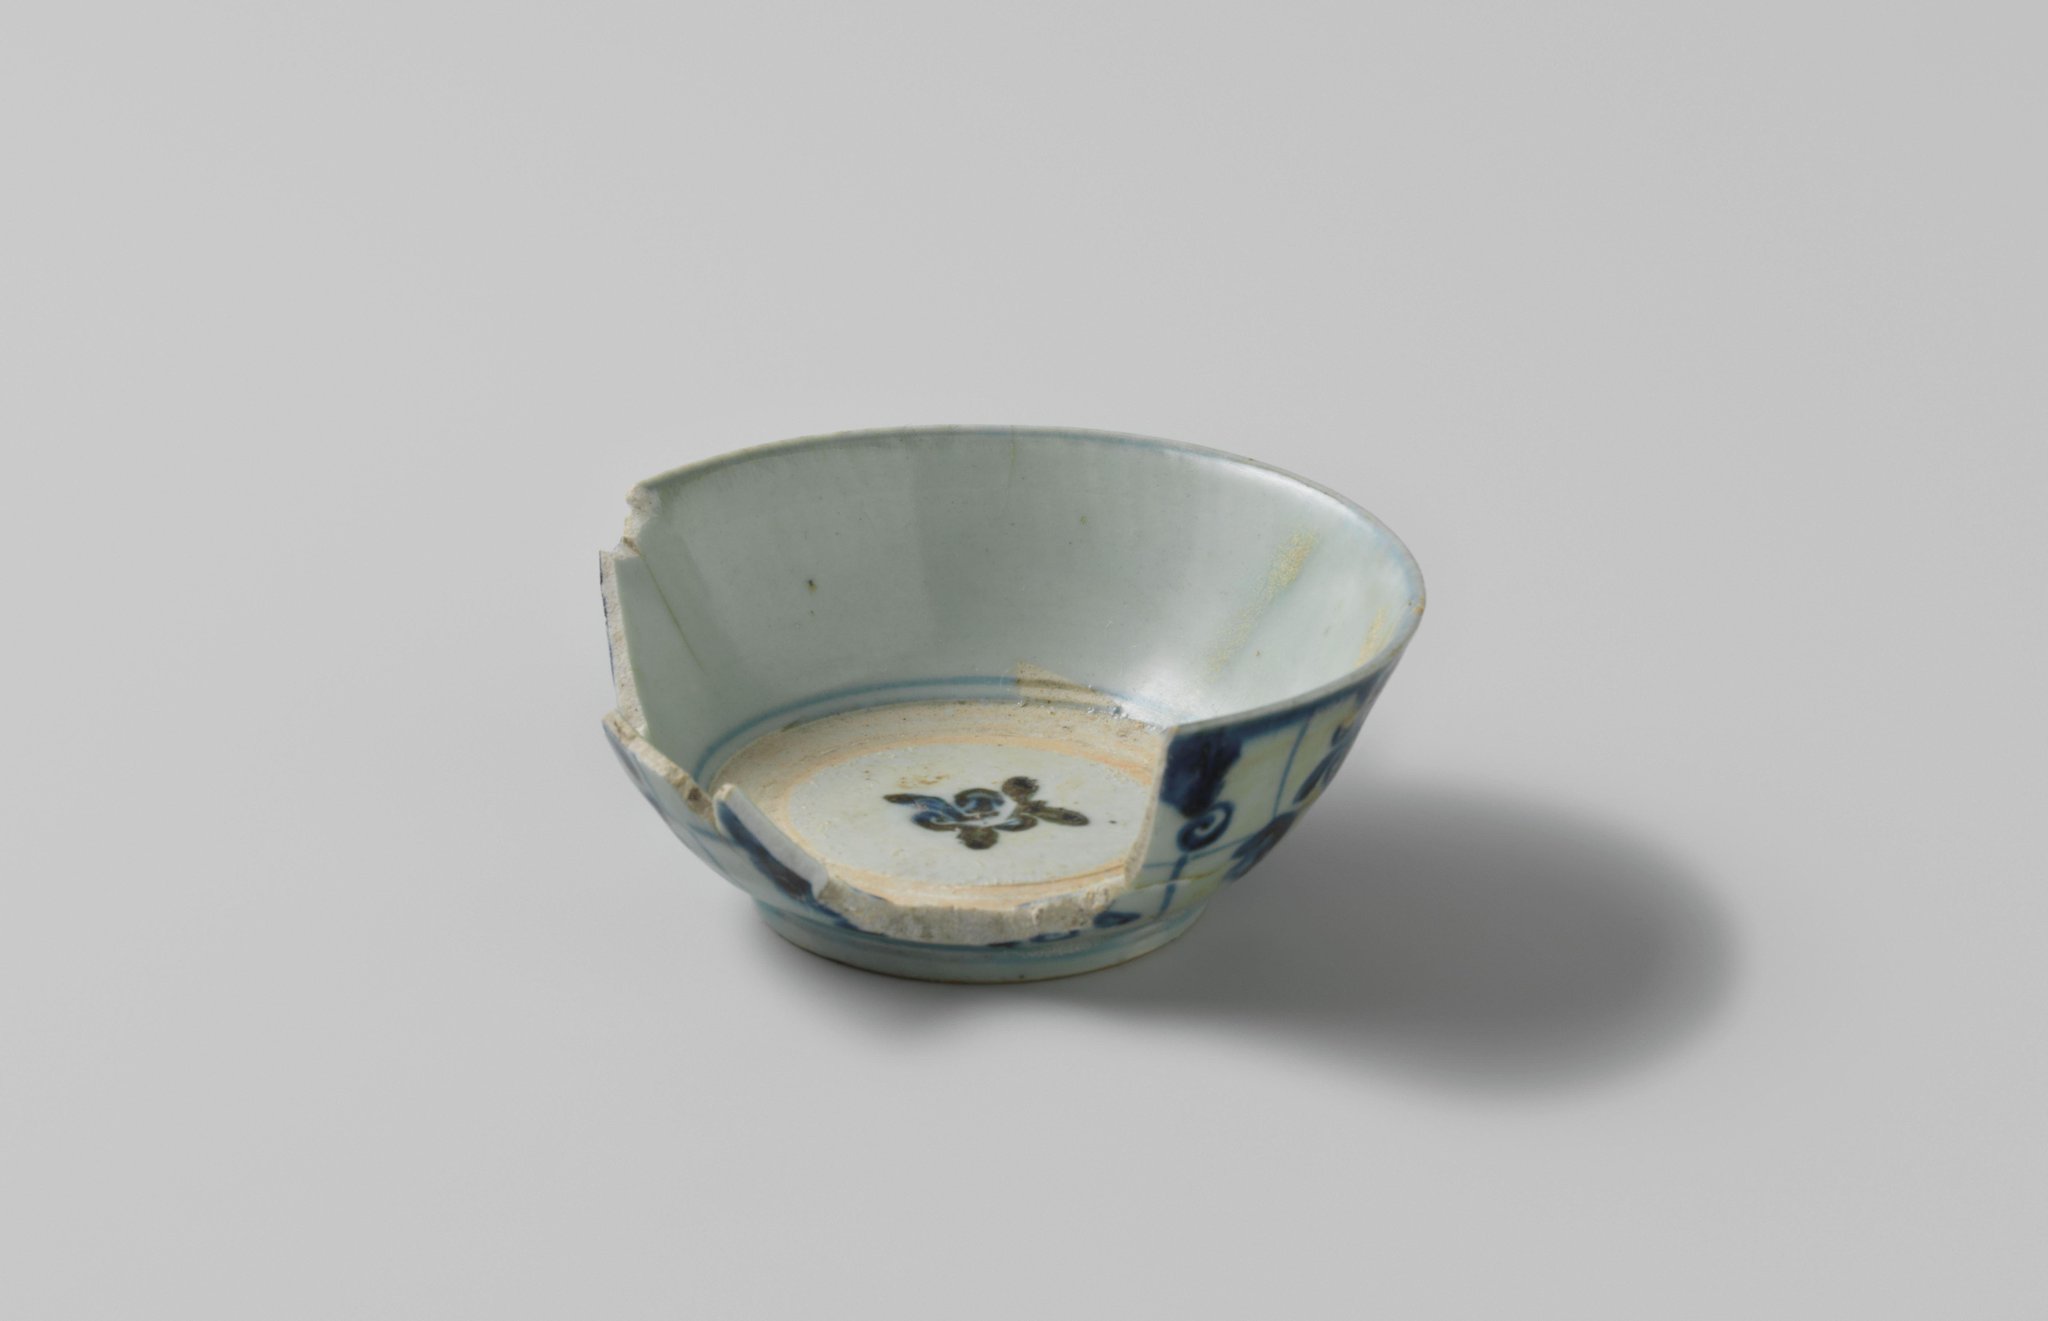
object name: bowl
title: Fragment kom uit V.O.C.-schip de 'Witte Leeuw'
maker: Anonymous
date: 1613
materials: porcelain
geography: shantou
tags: verenigde oostindische compagnie, sint-helena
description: A bowl with an unglazed ring. The unglazed ring shows traces of glaze. The central motive has been blemished because of another bowl having been placed on it.